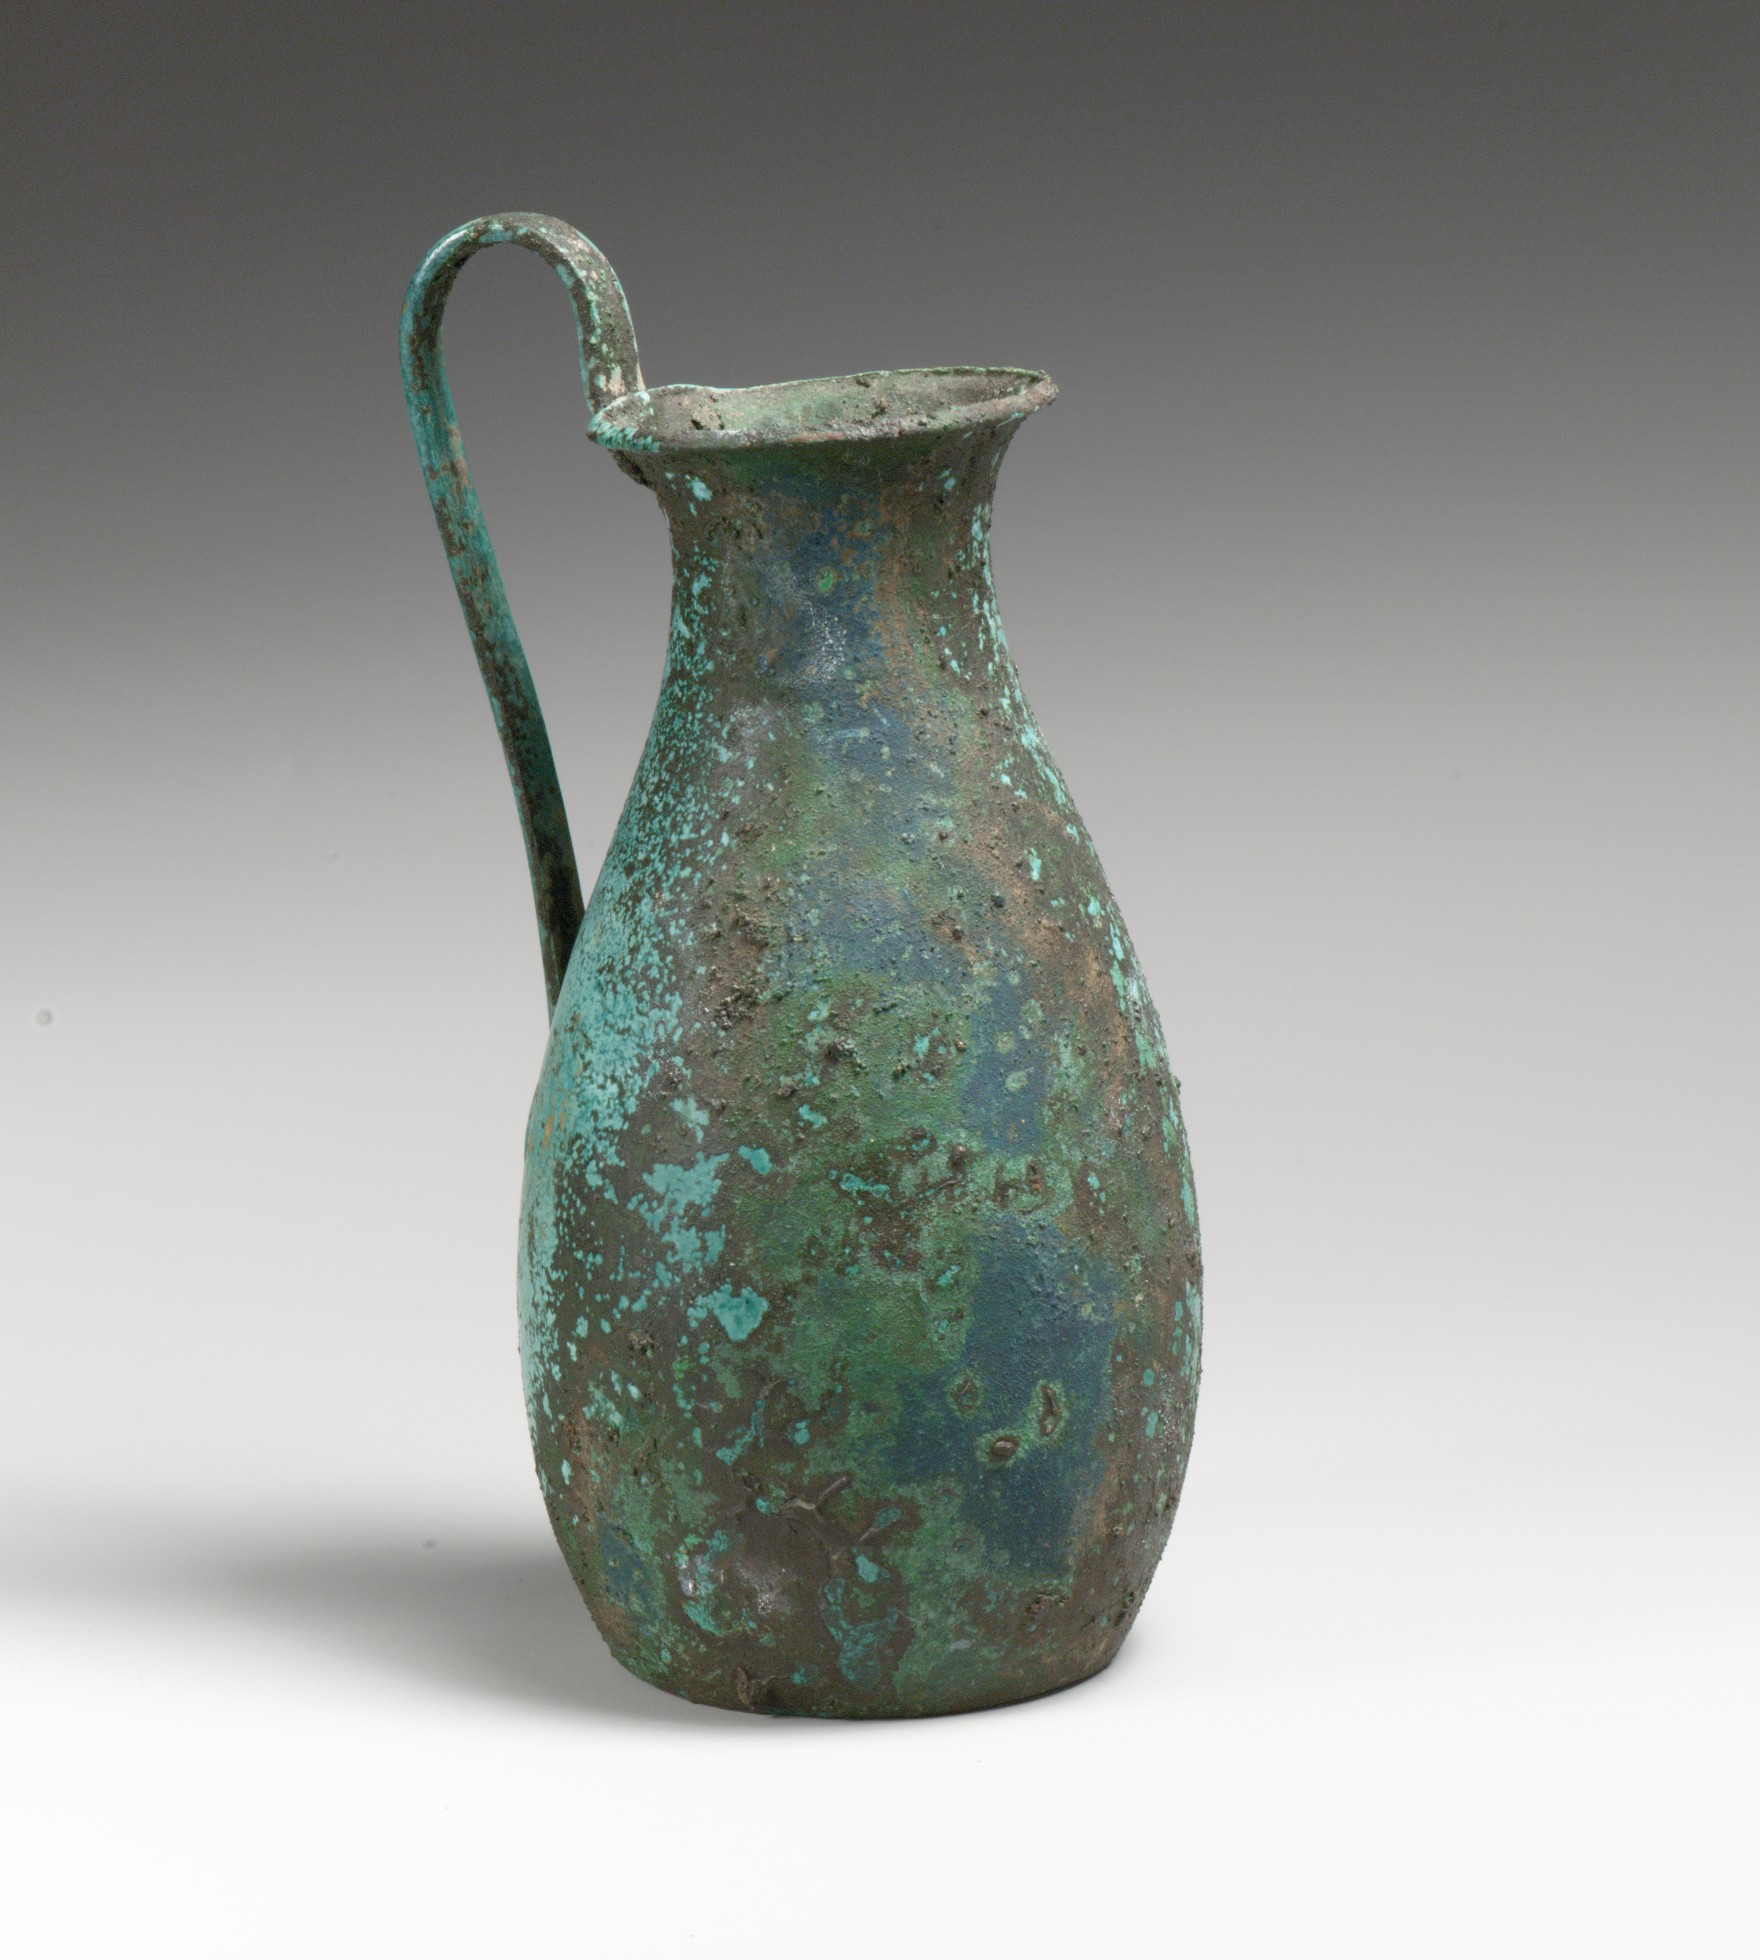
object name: olpe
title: Bronze oinochoe: olpe (jug)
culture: etruscan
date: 600-501 BCE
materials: bronze